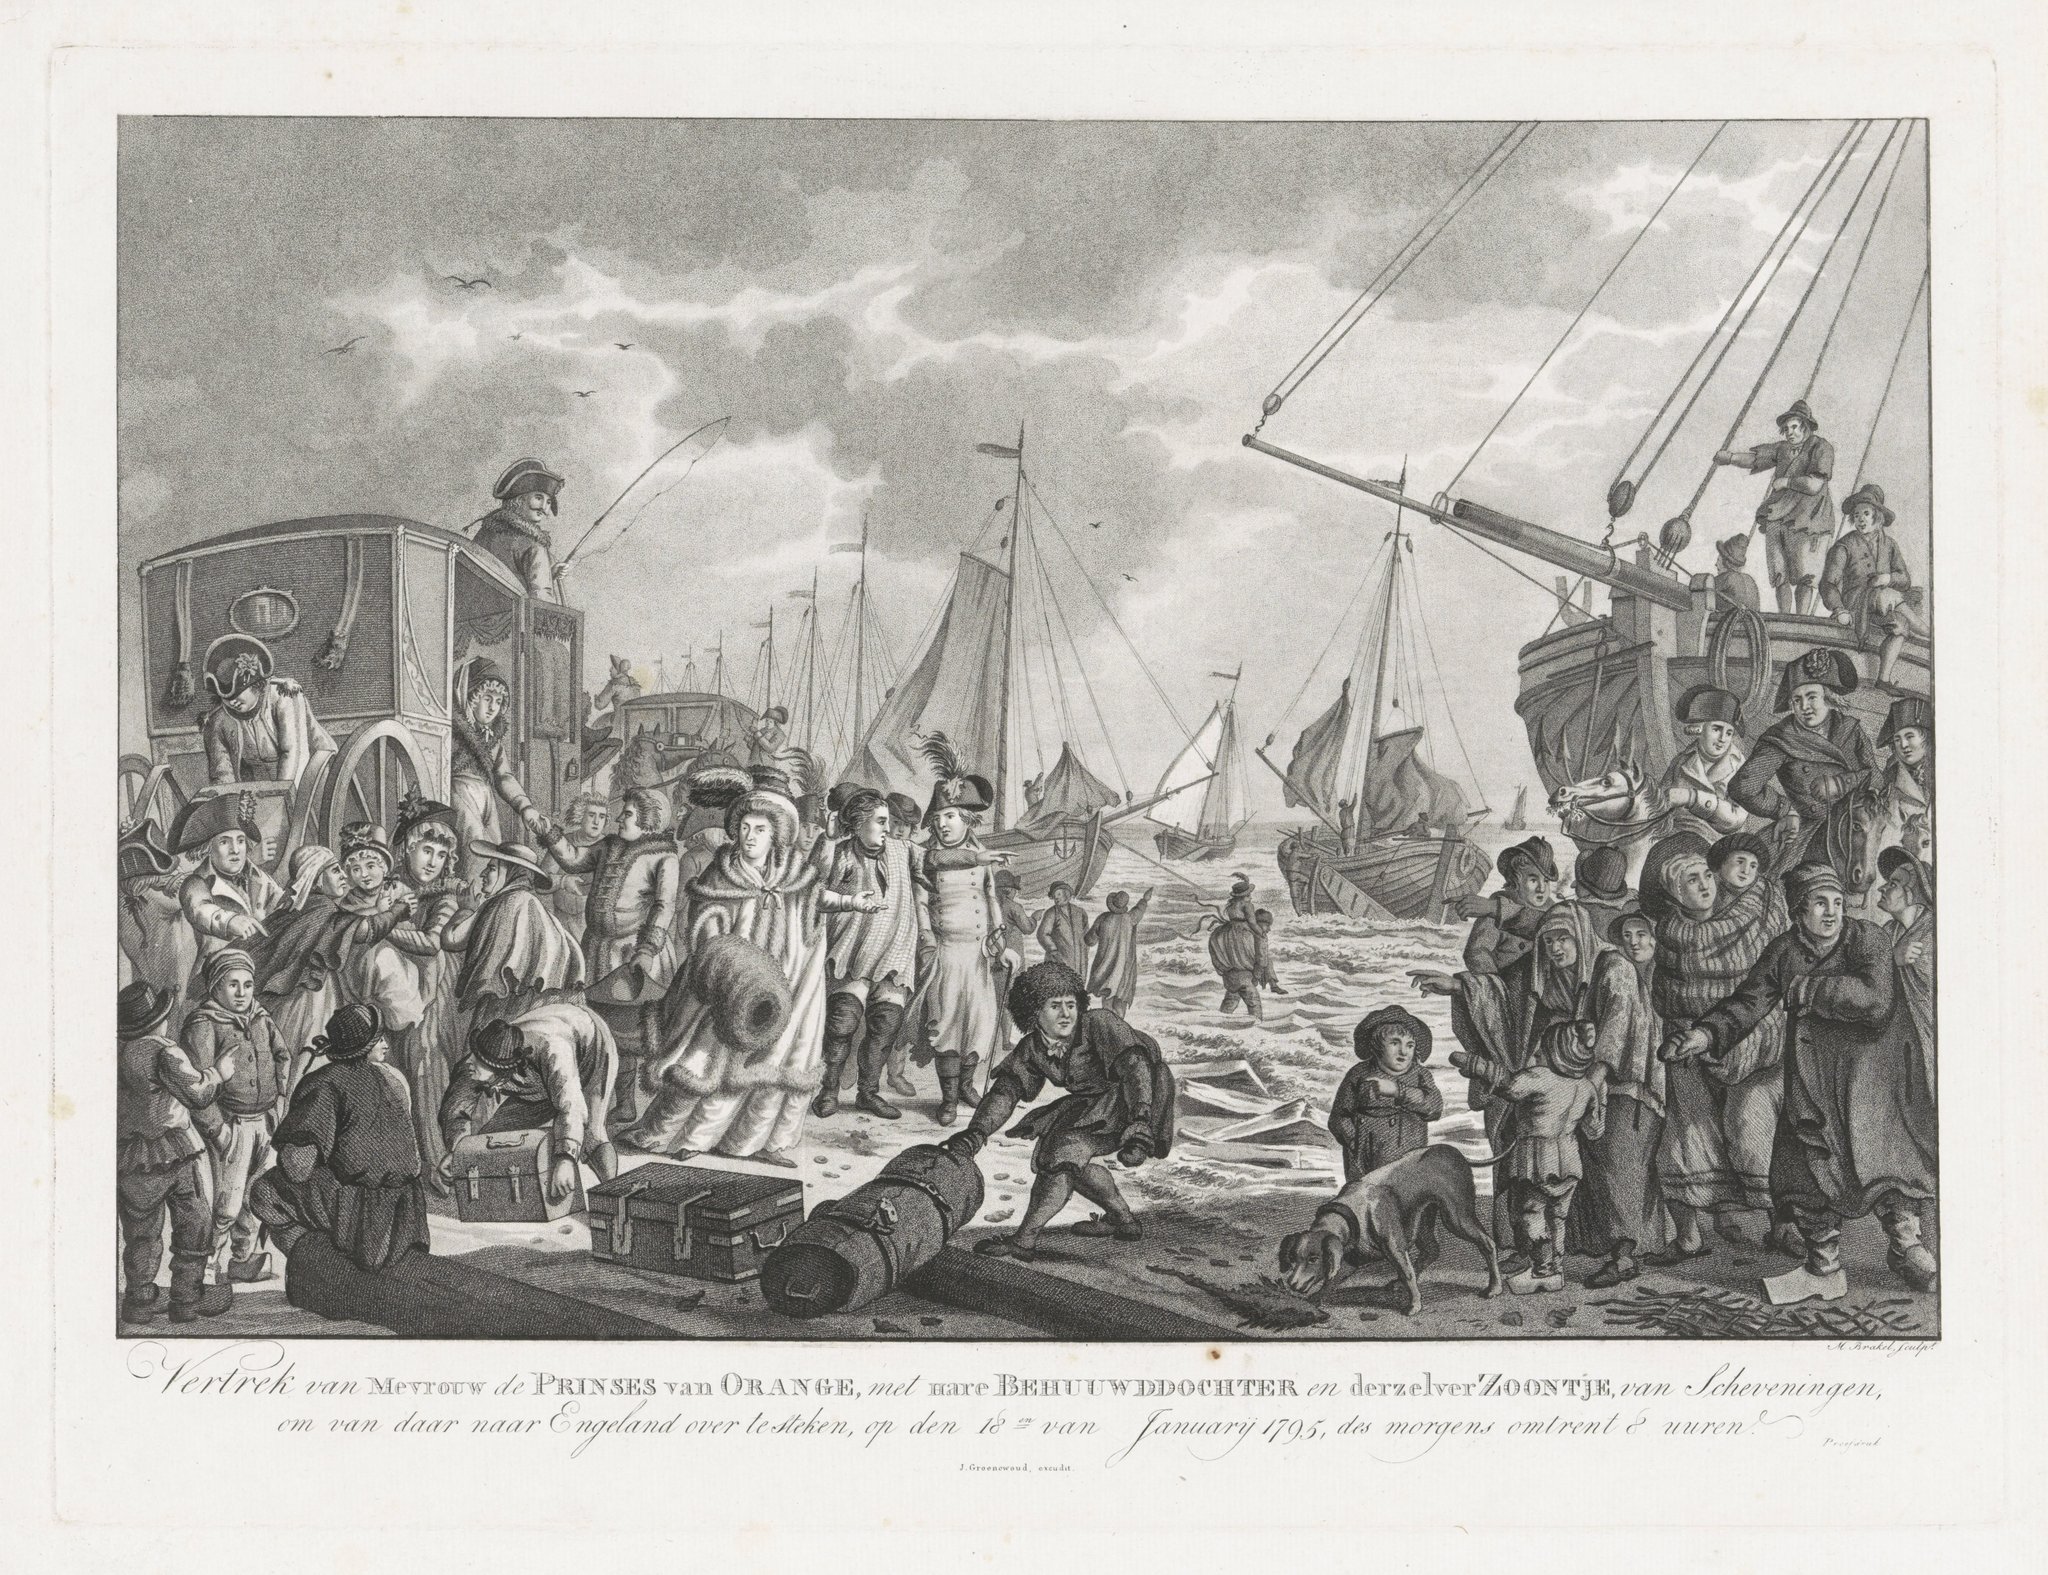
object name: print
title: Vertrek van de prinses van Oranje naar Engeland, 1795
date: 1795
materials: paper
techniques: engraving, etching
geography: northern netherlands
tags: berlin, draughtsman, wilhelmina of prussia (princess of orange), the hague, wilhelmina frederica louisa (koningin der nederlanden), departure ~ travelling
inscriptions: collector's mark: Lugt 2228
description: Vertrek van prinses Wilhelmina van Pruisen met haar schoondochter en kleinzoon vanaf Scheveningen naar Engeland, 18 januari 1795. Enkele koetsen met de prinses en haar gevolg op het strand van Scheveningen. Bagage en passagiers worden door het water naar een wachtende sloep gedragen. Links en rechts vissers en toegestroomde publiek. Zie pendant met het vertrek van prins Willem V uit Den Haag.